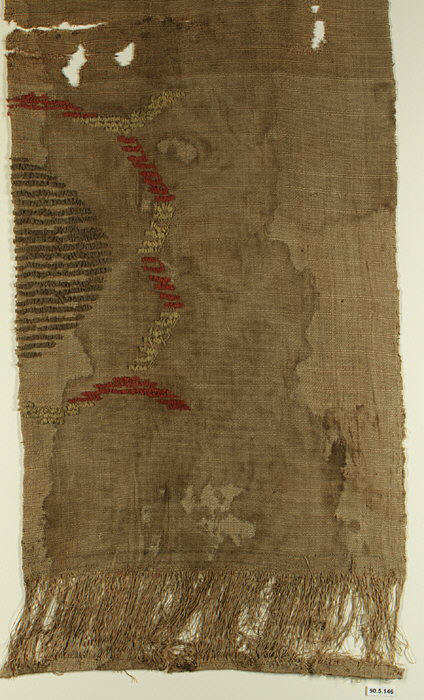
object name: textile fragment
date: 401-500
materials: linen, wool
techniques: weave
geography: egypt